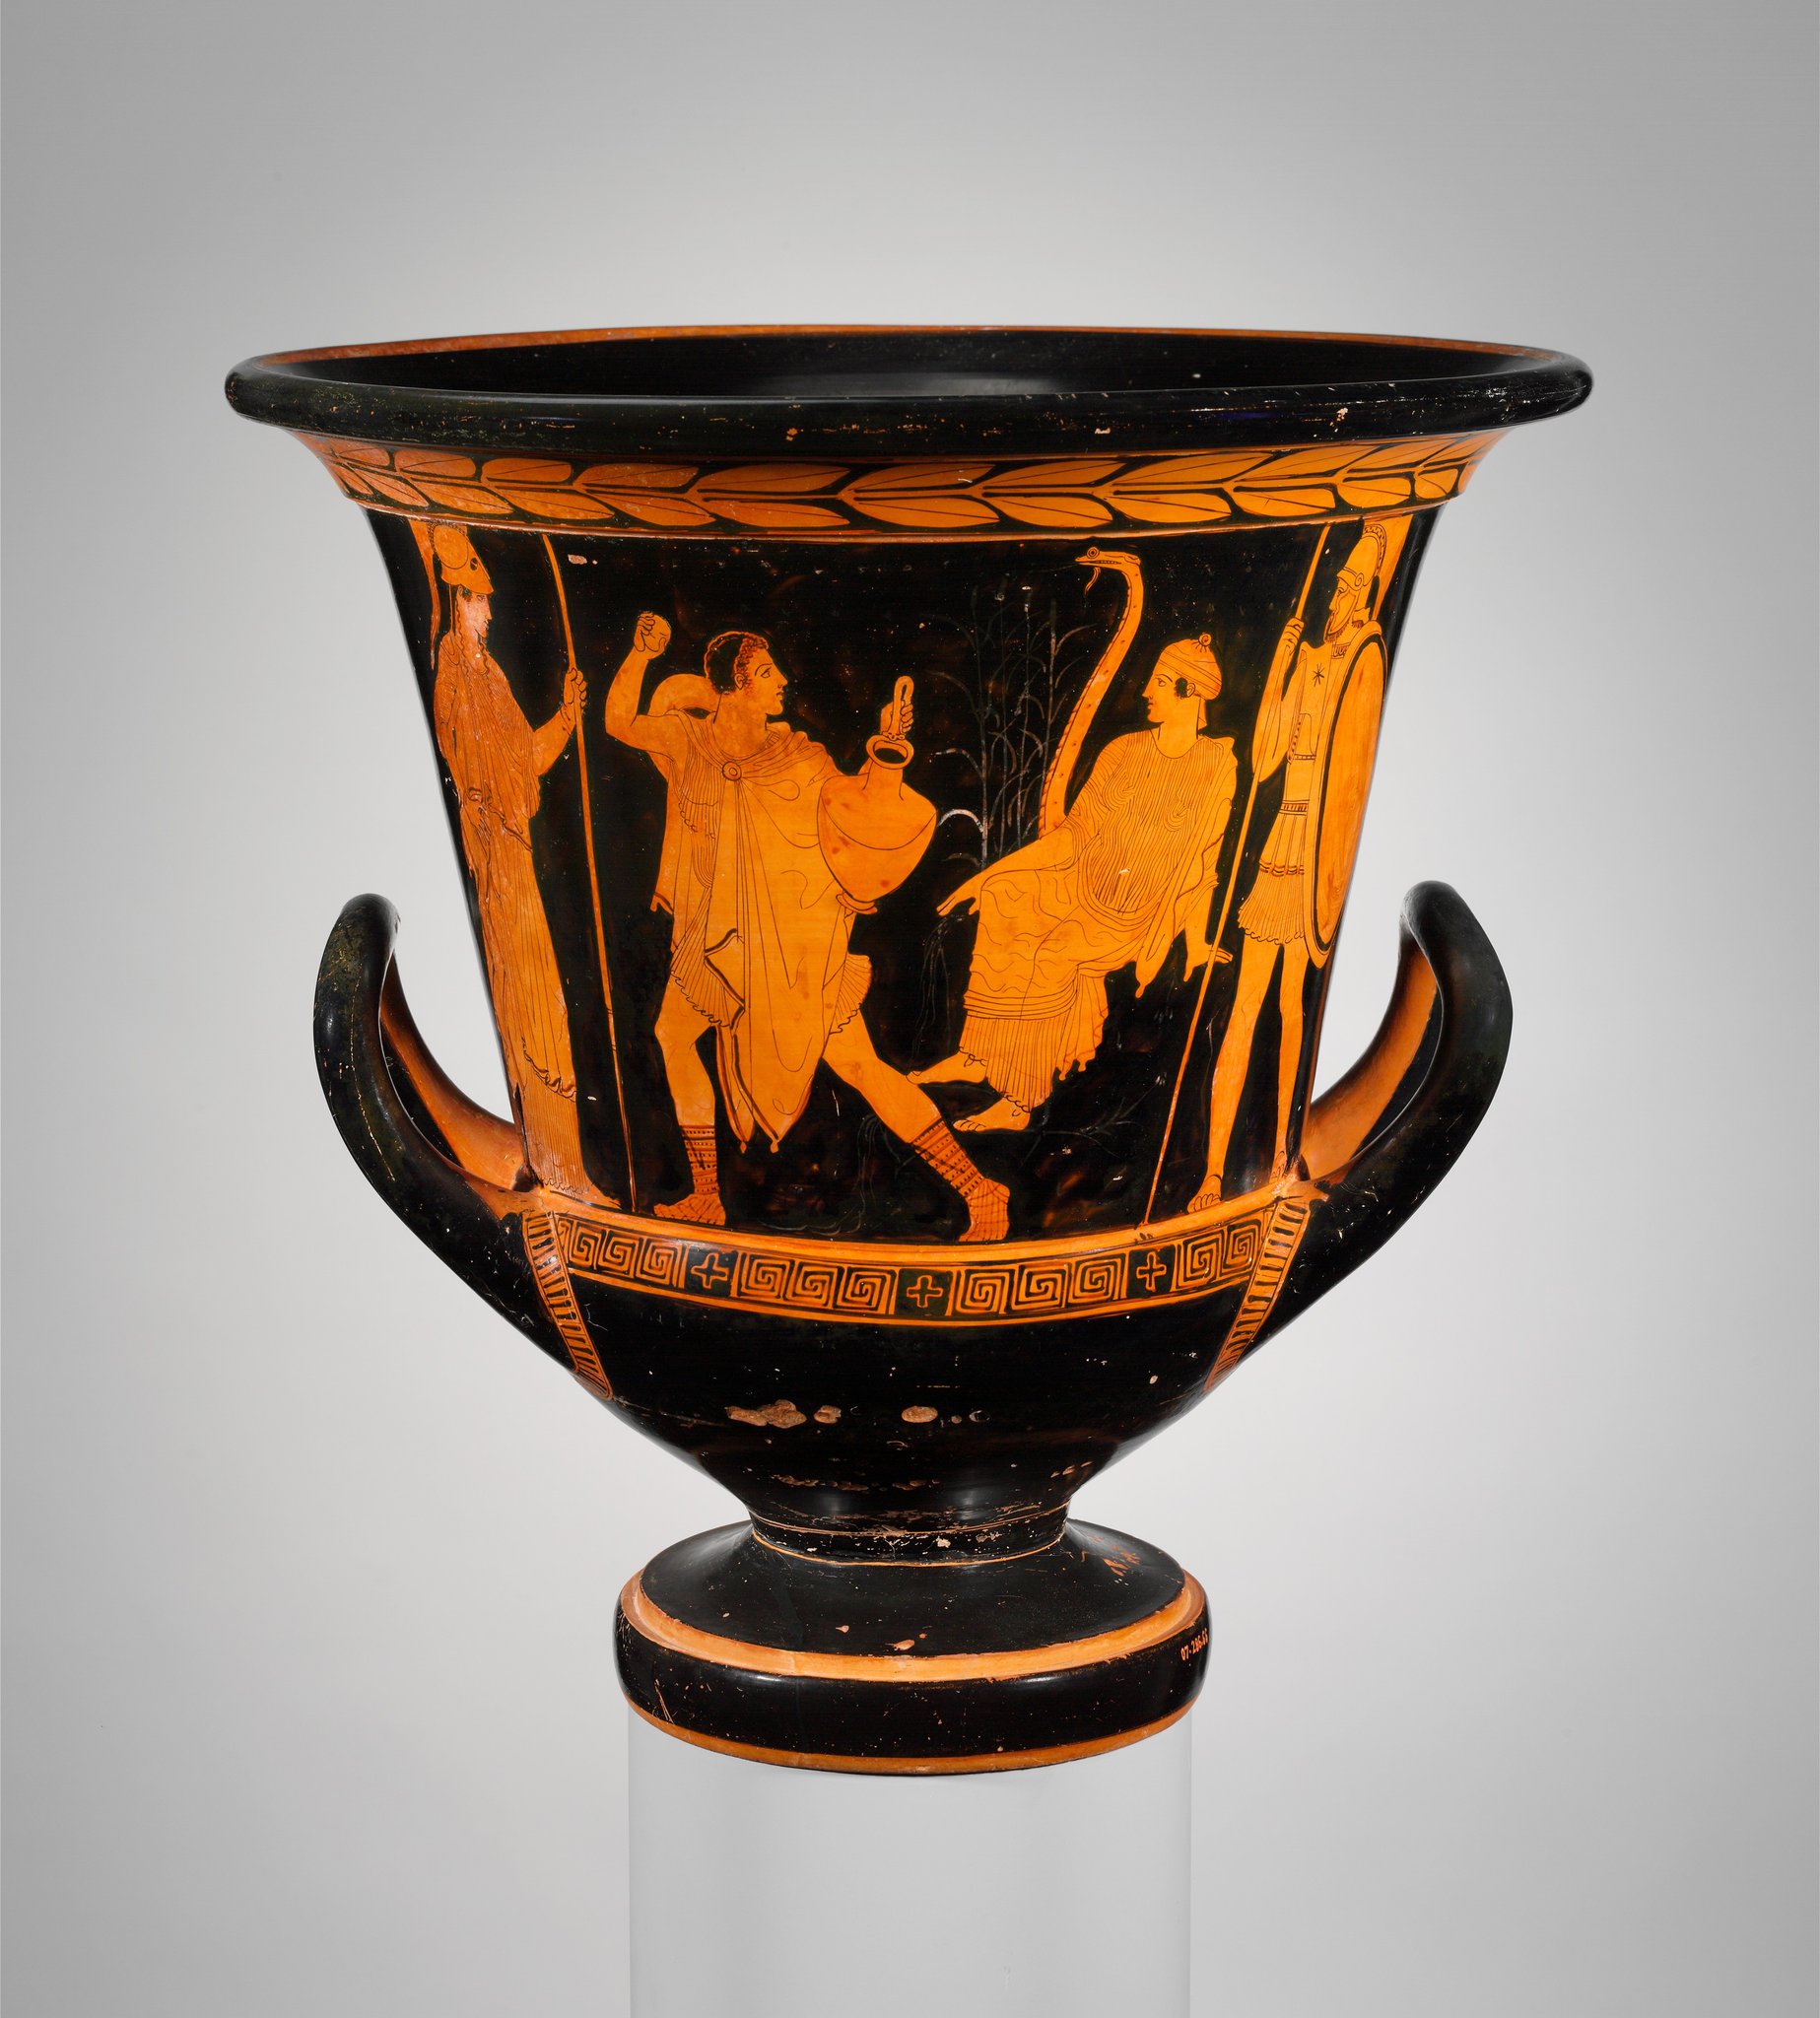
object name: calyx krater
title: Terracotta calyx-krater (bowl for mixing wine and water)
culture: greek, attic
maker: spreckles painter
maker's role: artist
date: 450 BCE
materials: terracotta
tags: kings,men,snakes